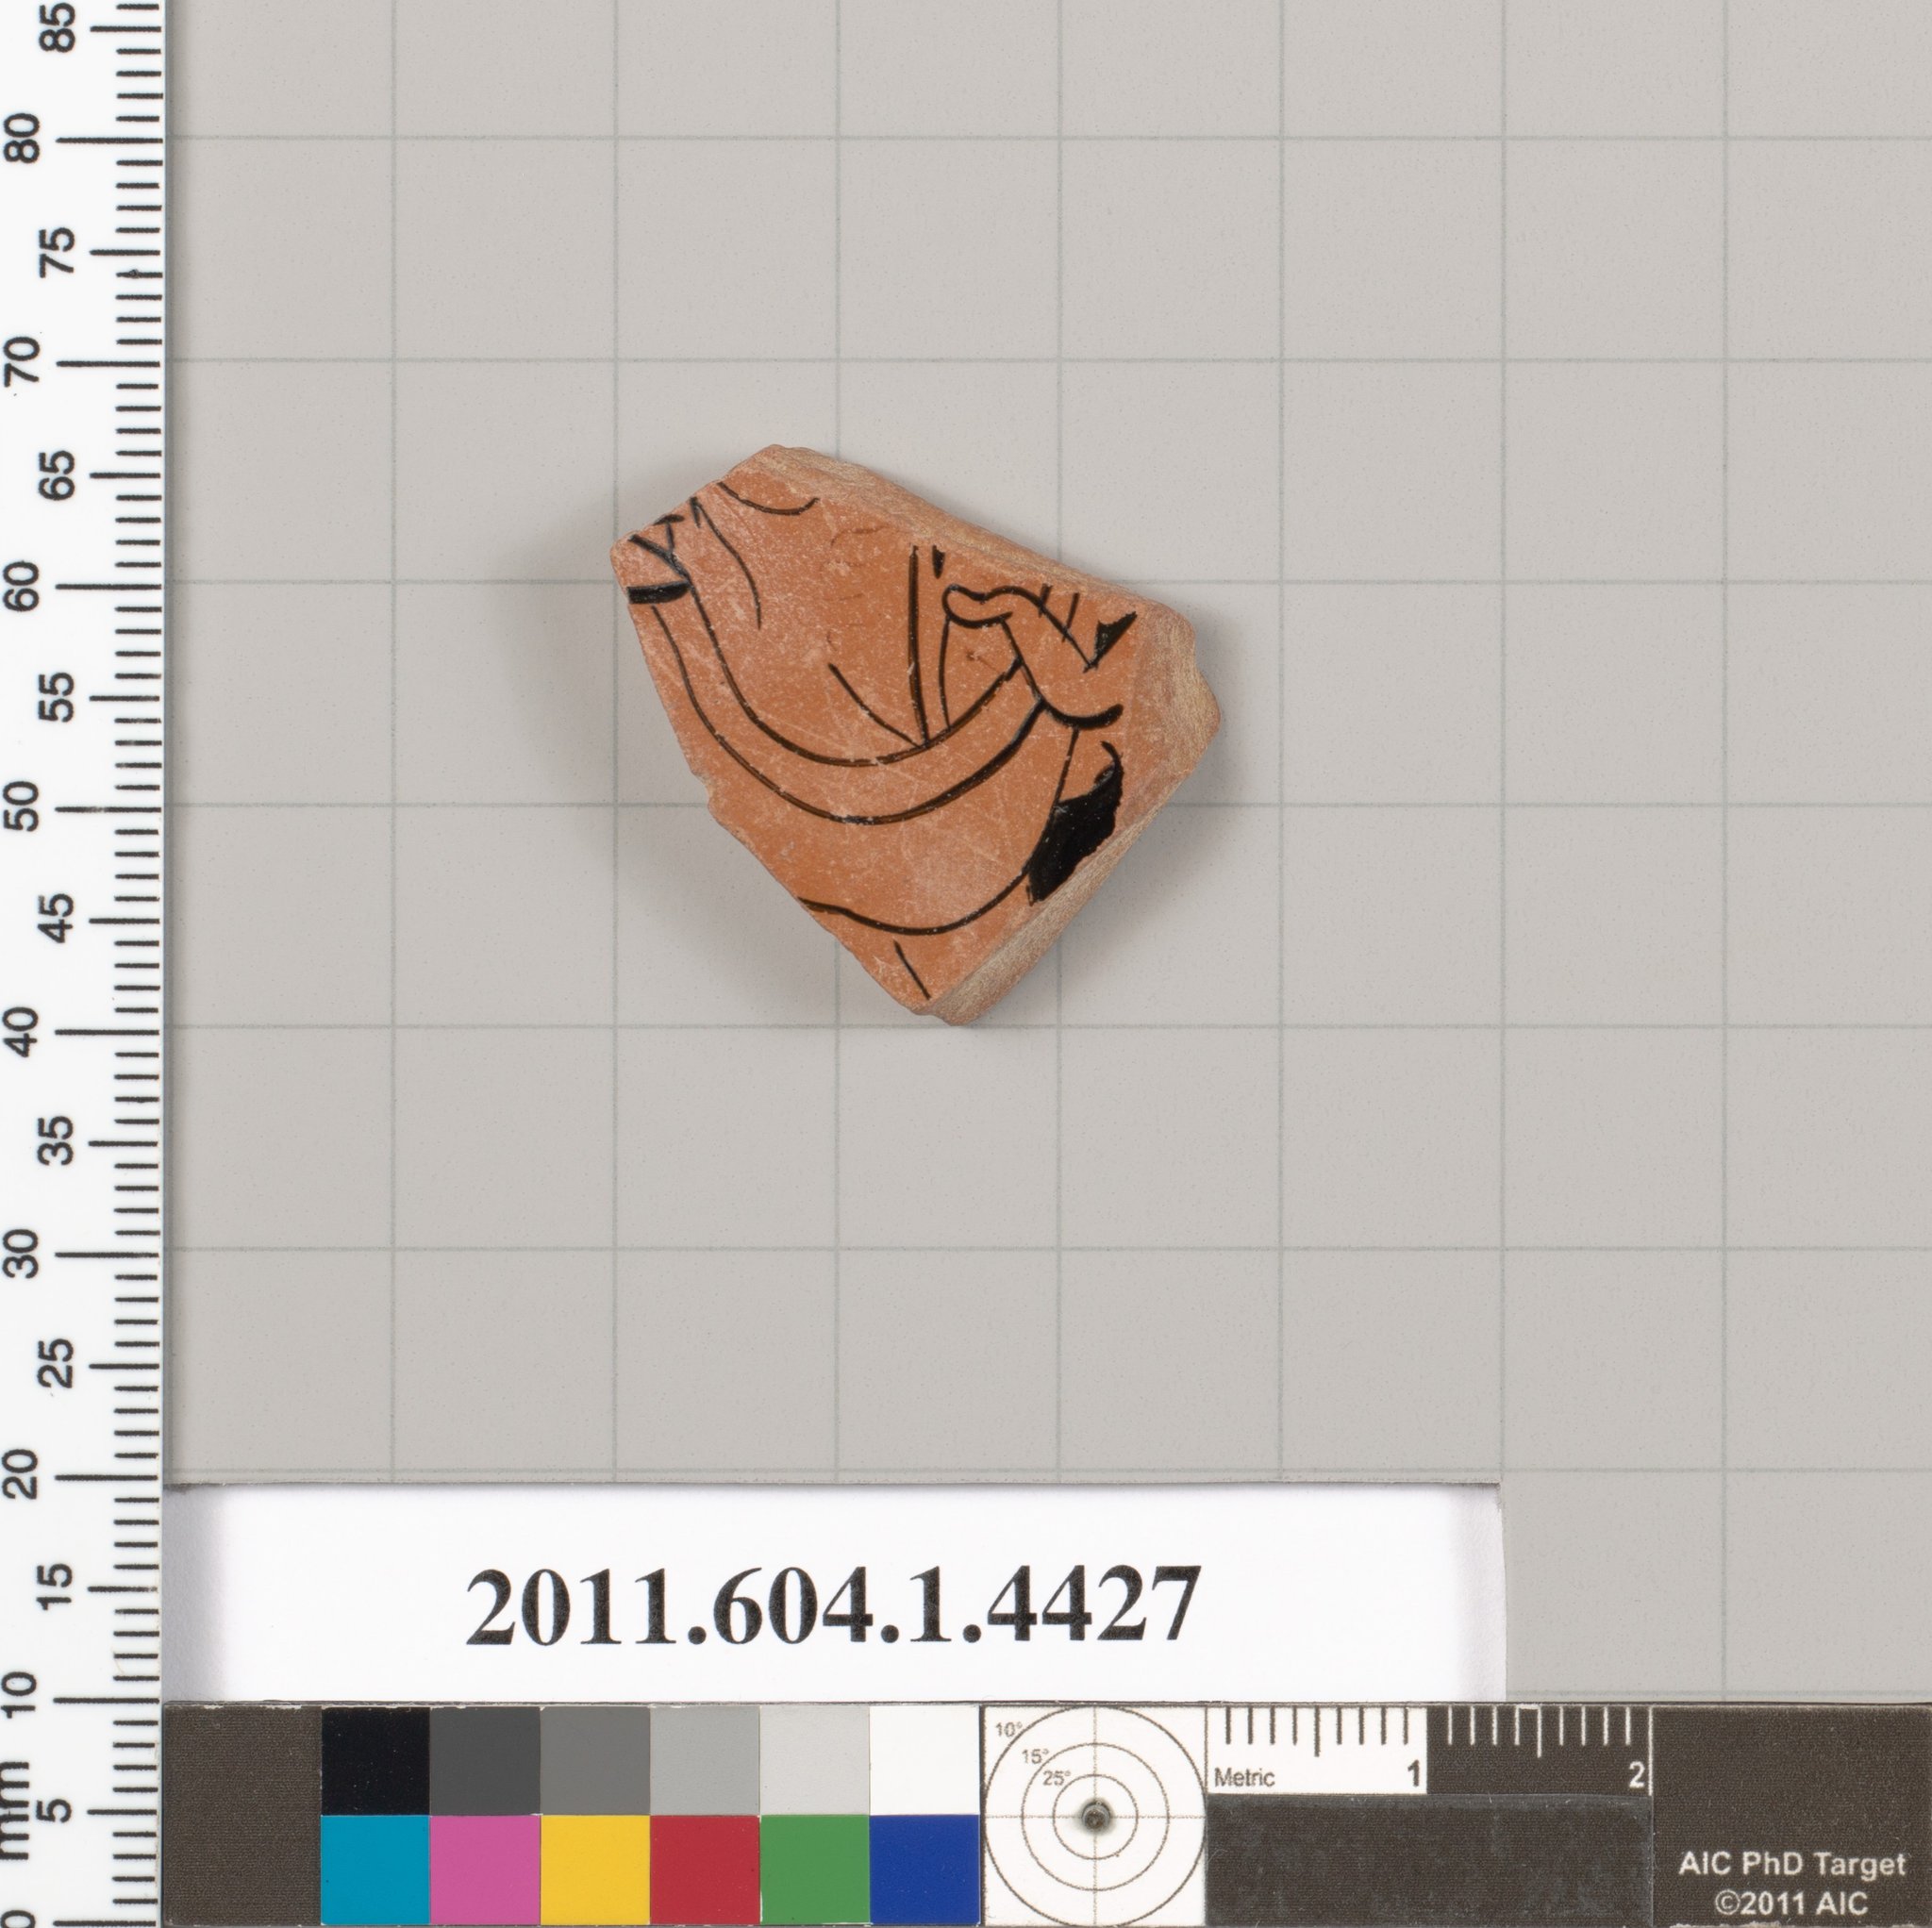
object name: kylix fragment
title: Terracotta fragment of a kylix (drinking cup)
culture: greek, attic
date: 490-470 BCE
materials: terracotta